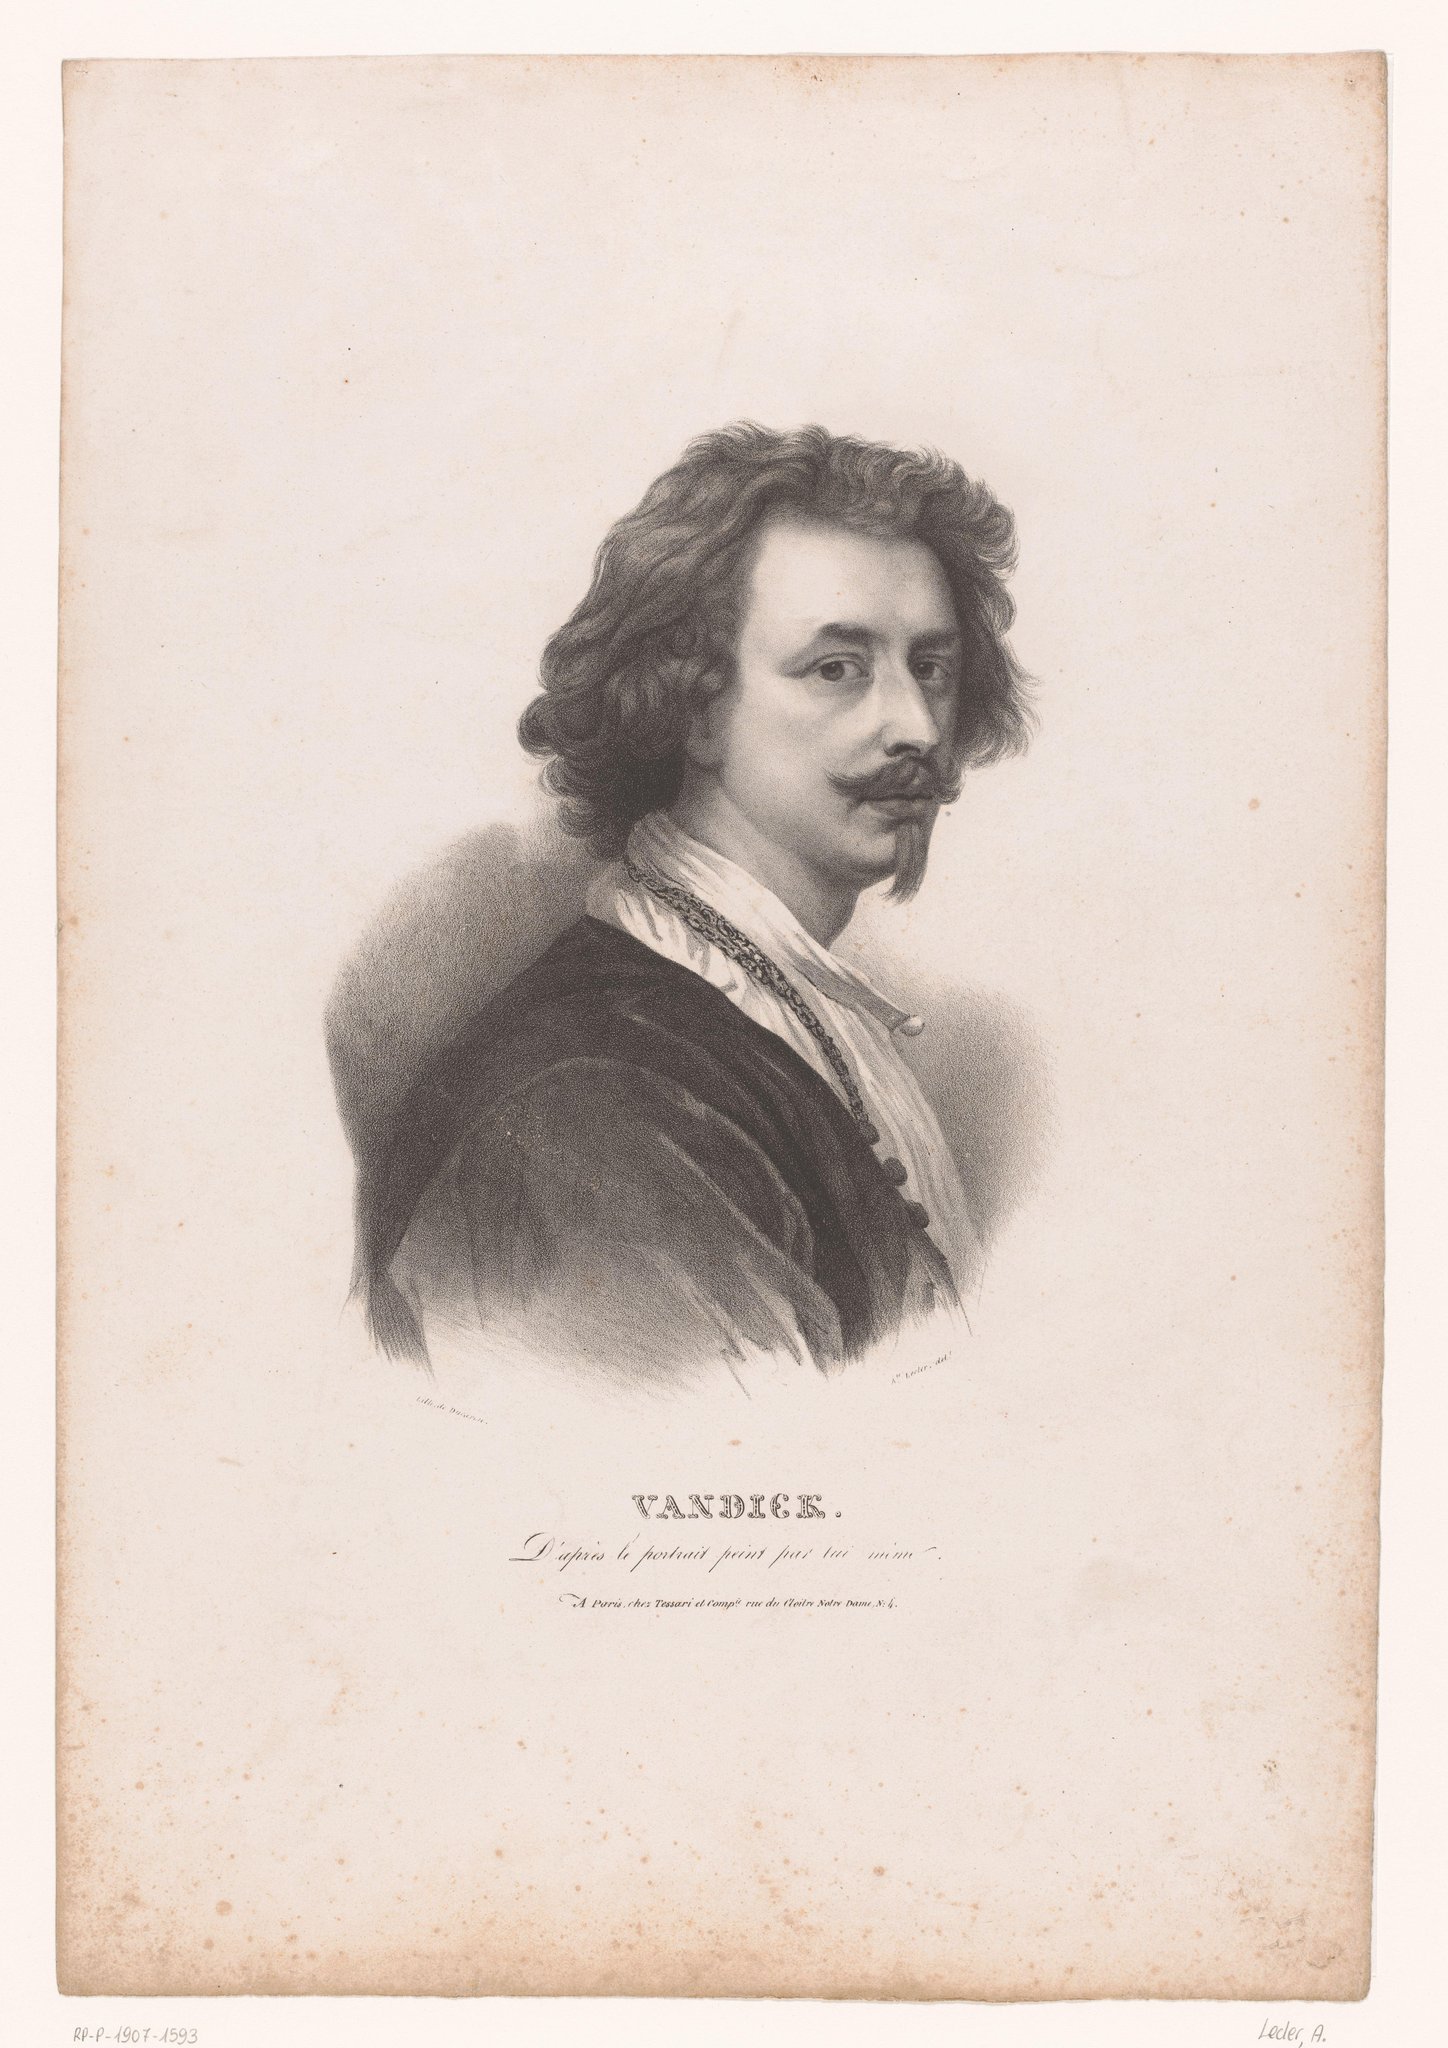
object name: print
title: Portret van Antoon van Dyck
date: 1825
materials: paper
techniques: lithograph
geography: paris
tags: antwerp, london, painter, print maker, draughtsman, anthony van dyck, historical persons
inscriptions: collector's mark: Lugt 2228a